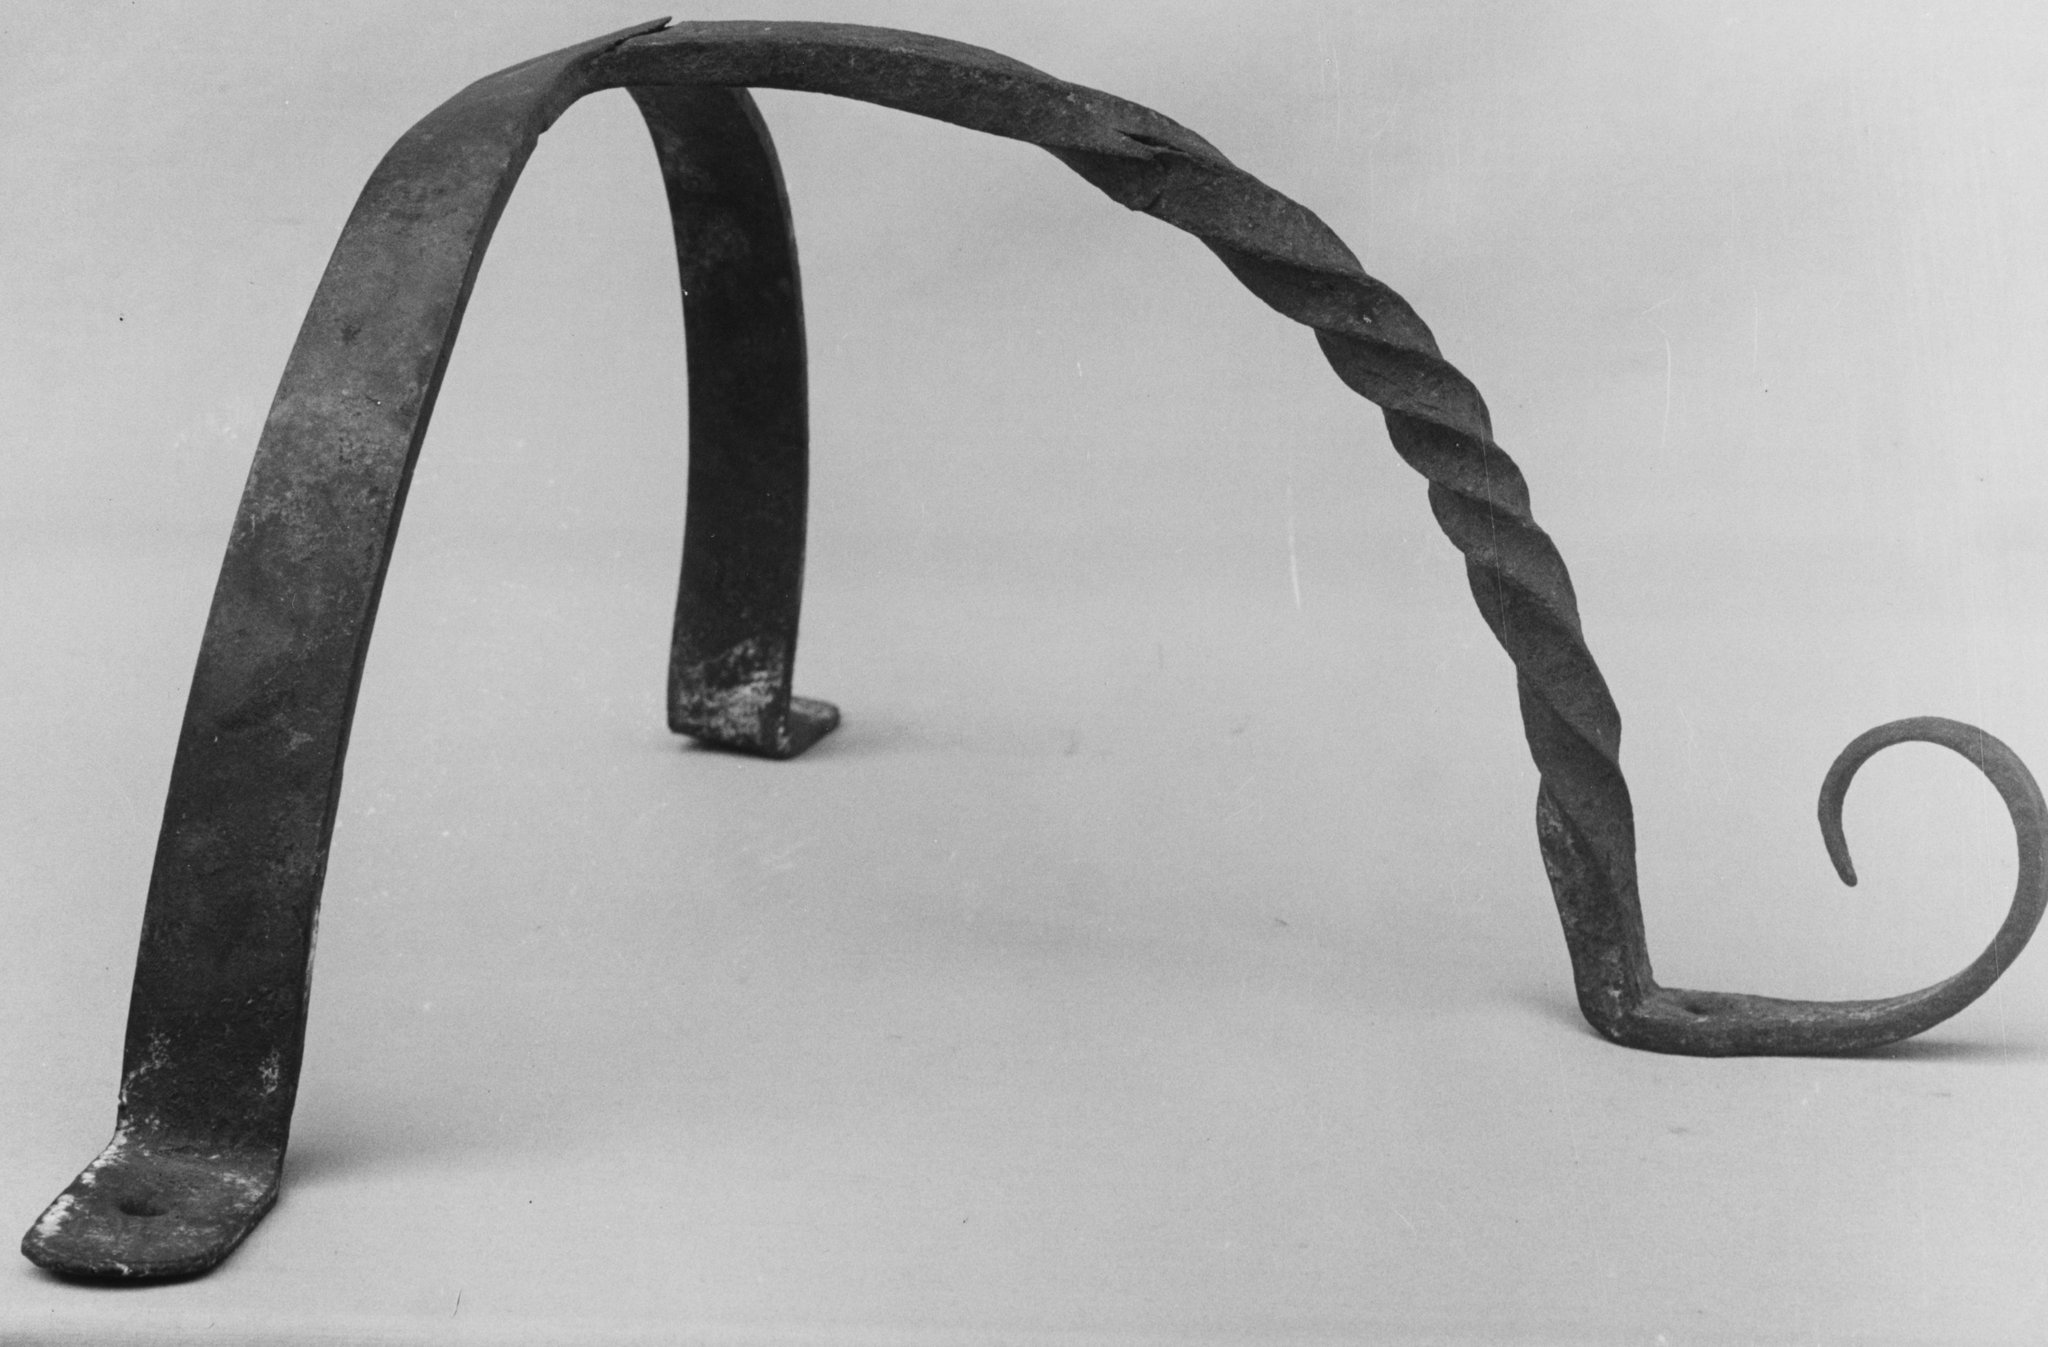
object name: foot scraper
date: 1700-1800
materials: iron